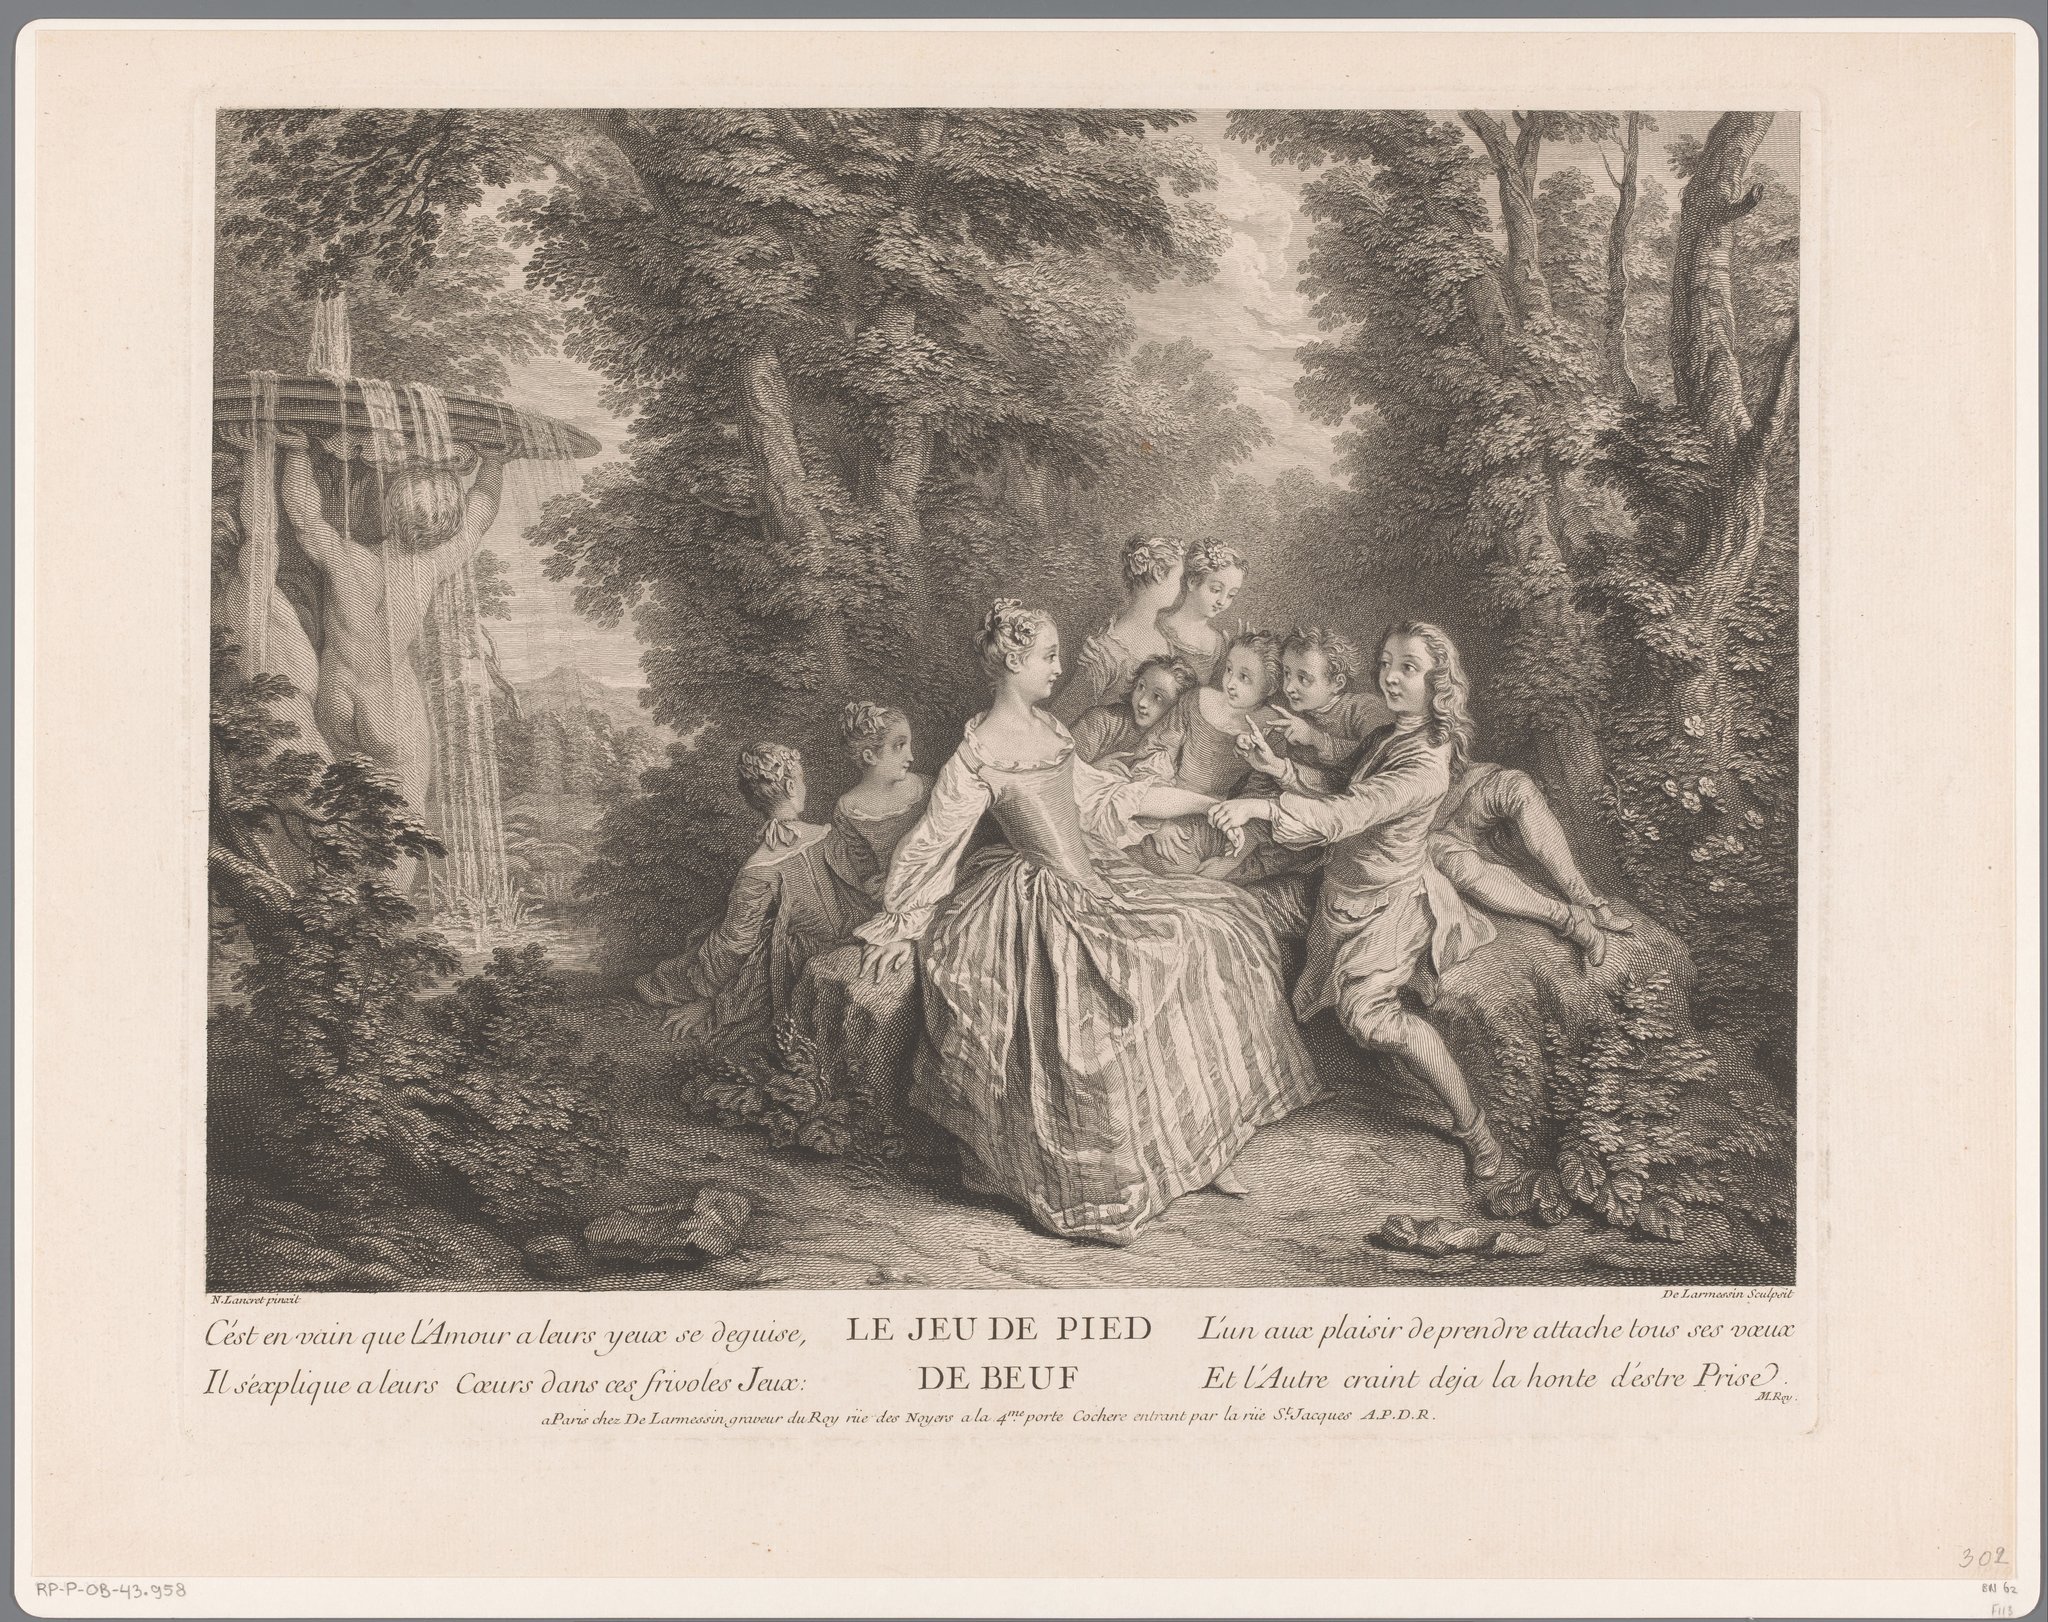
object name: print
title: Groep jonge mensen speelt een spel bij een fontein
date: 1740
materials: paper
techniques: engraving, etching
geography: paris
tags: simple hand games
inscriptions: watermark, collector's mark: Lugt 240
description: Elegant gezelschap speelt 'Pied de Boeuf' in een park.